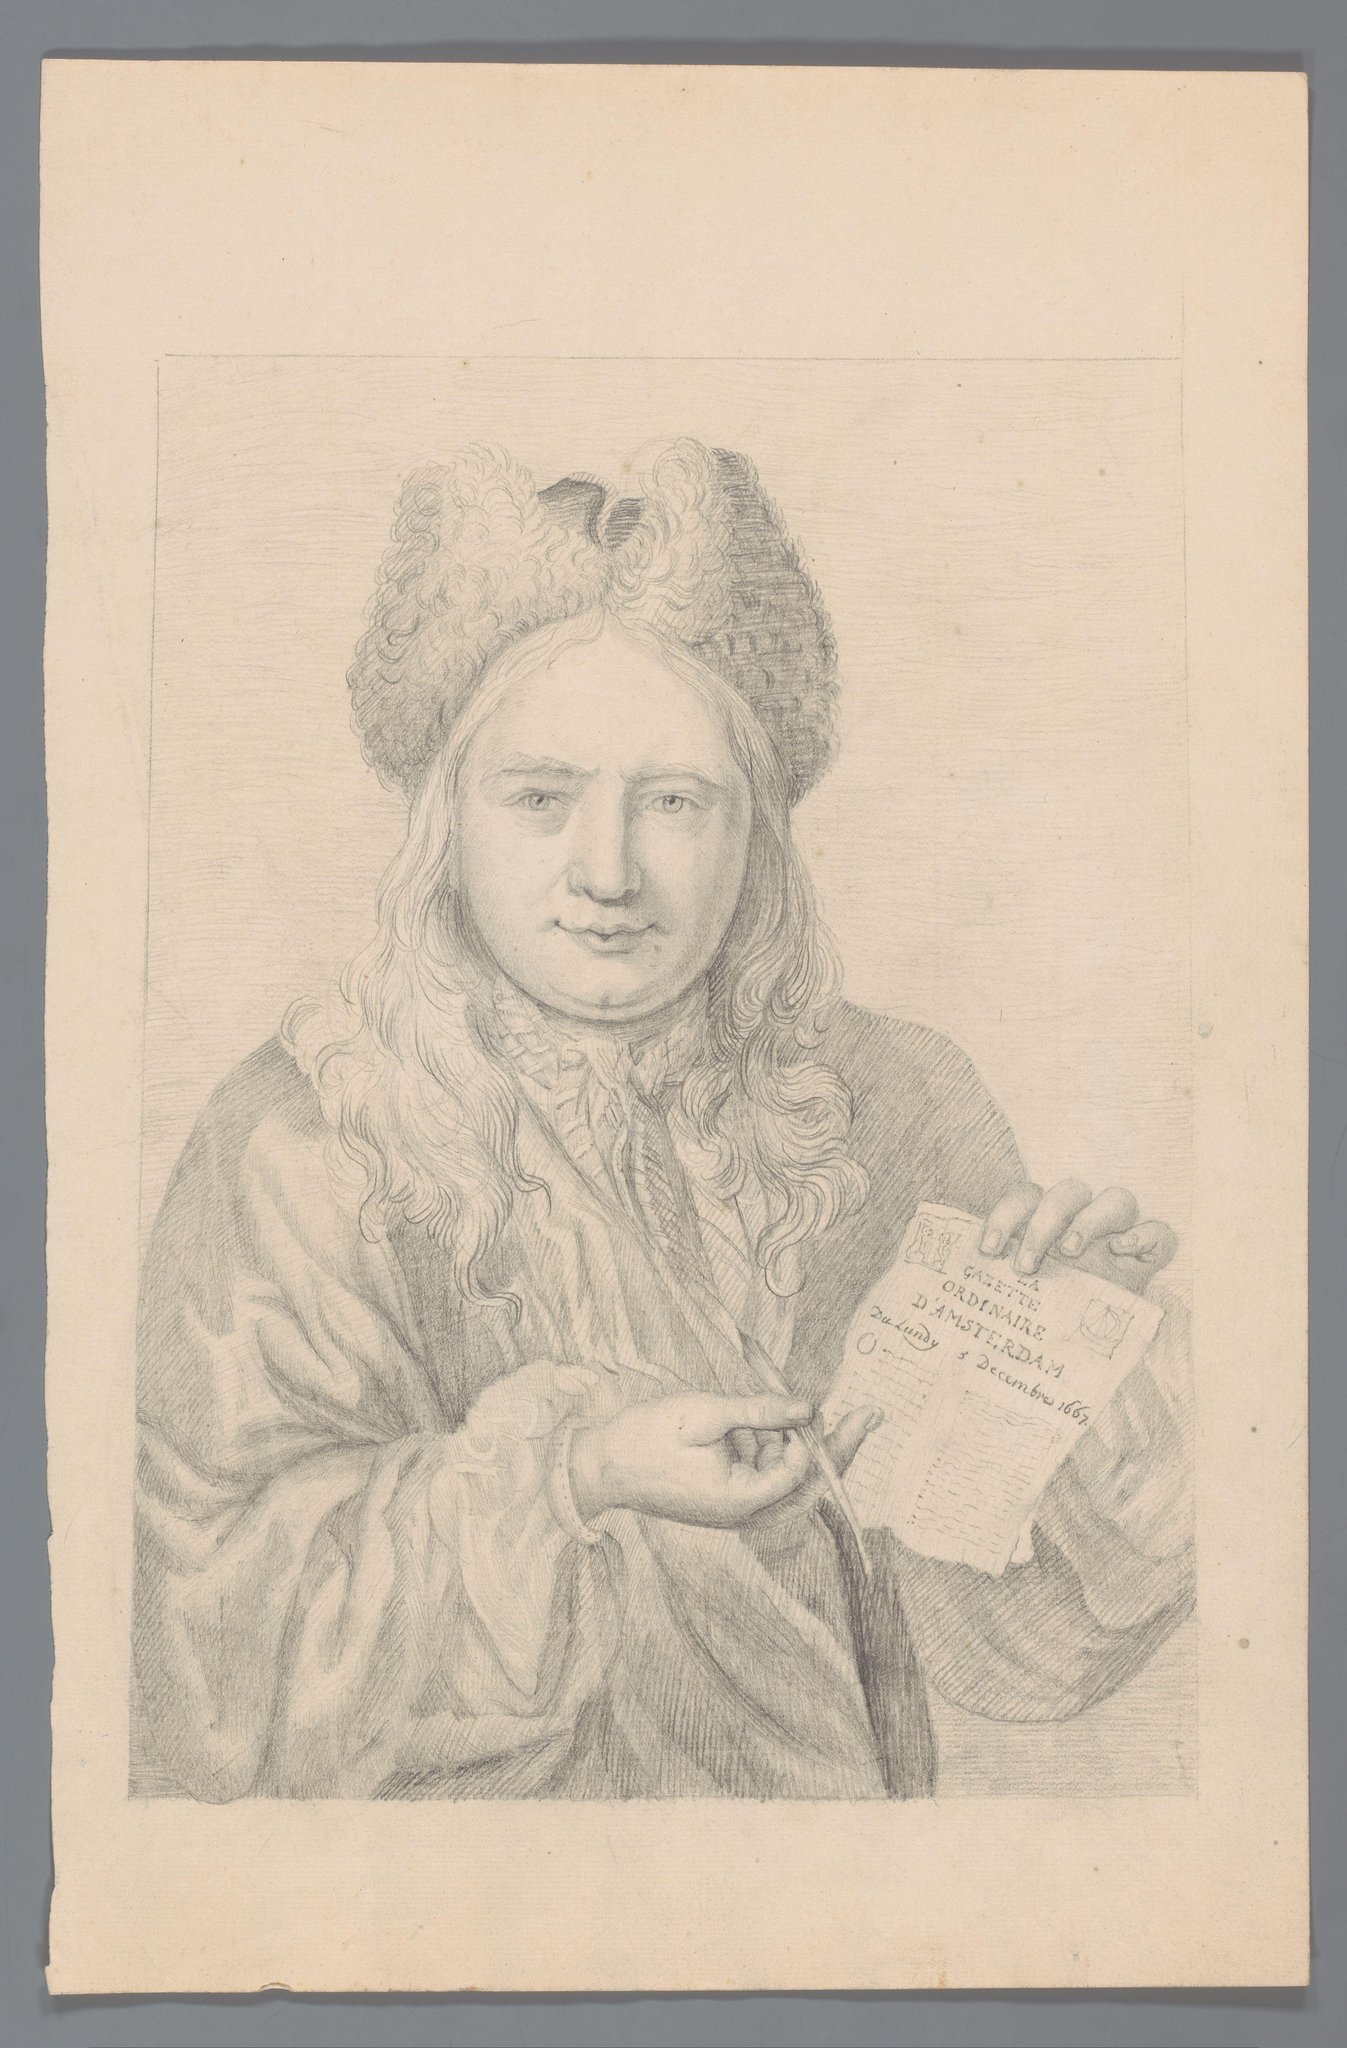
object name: drawing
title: Staande man met schrijfinstrument en Gazette ordinaire d'Amsterdam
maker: Anonymous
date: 1700-1799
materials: paper, pencil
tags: standing figure, pen, newspaper, news-sheet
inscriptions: collector's mark: Lugt 2165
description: De man draagt een muts, das en jast een wijst naar de krantenpagina waarop de datum maandag 5 december 1667 vermeld staat.